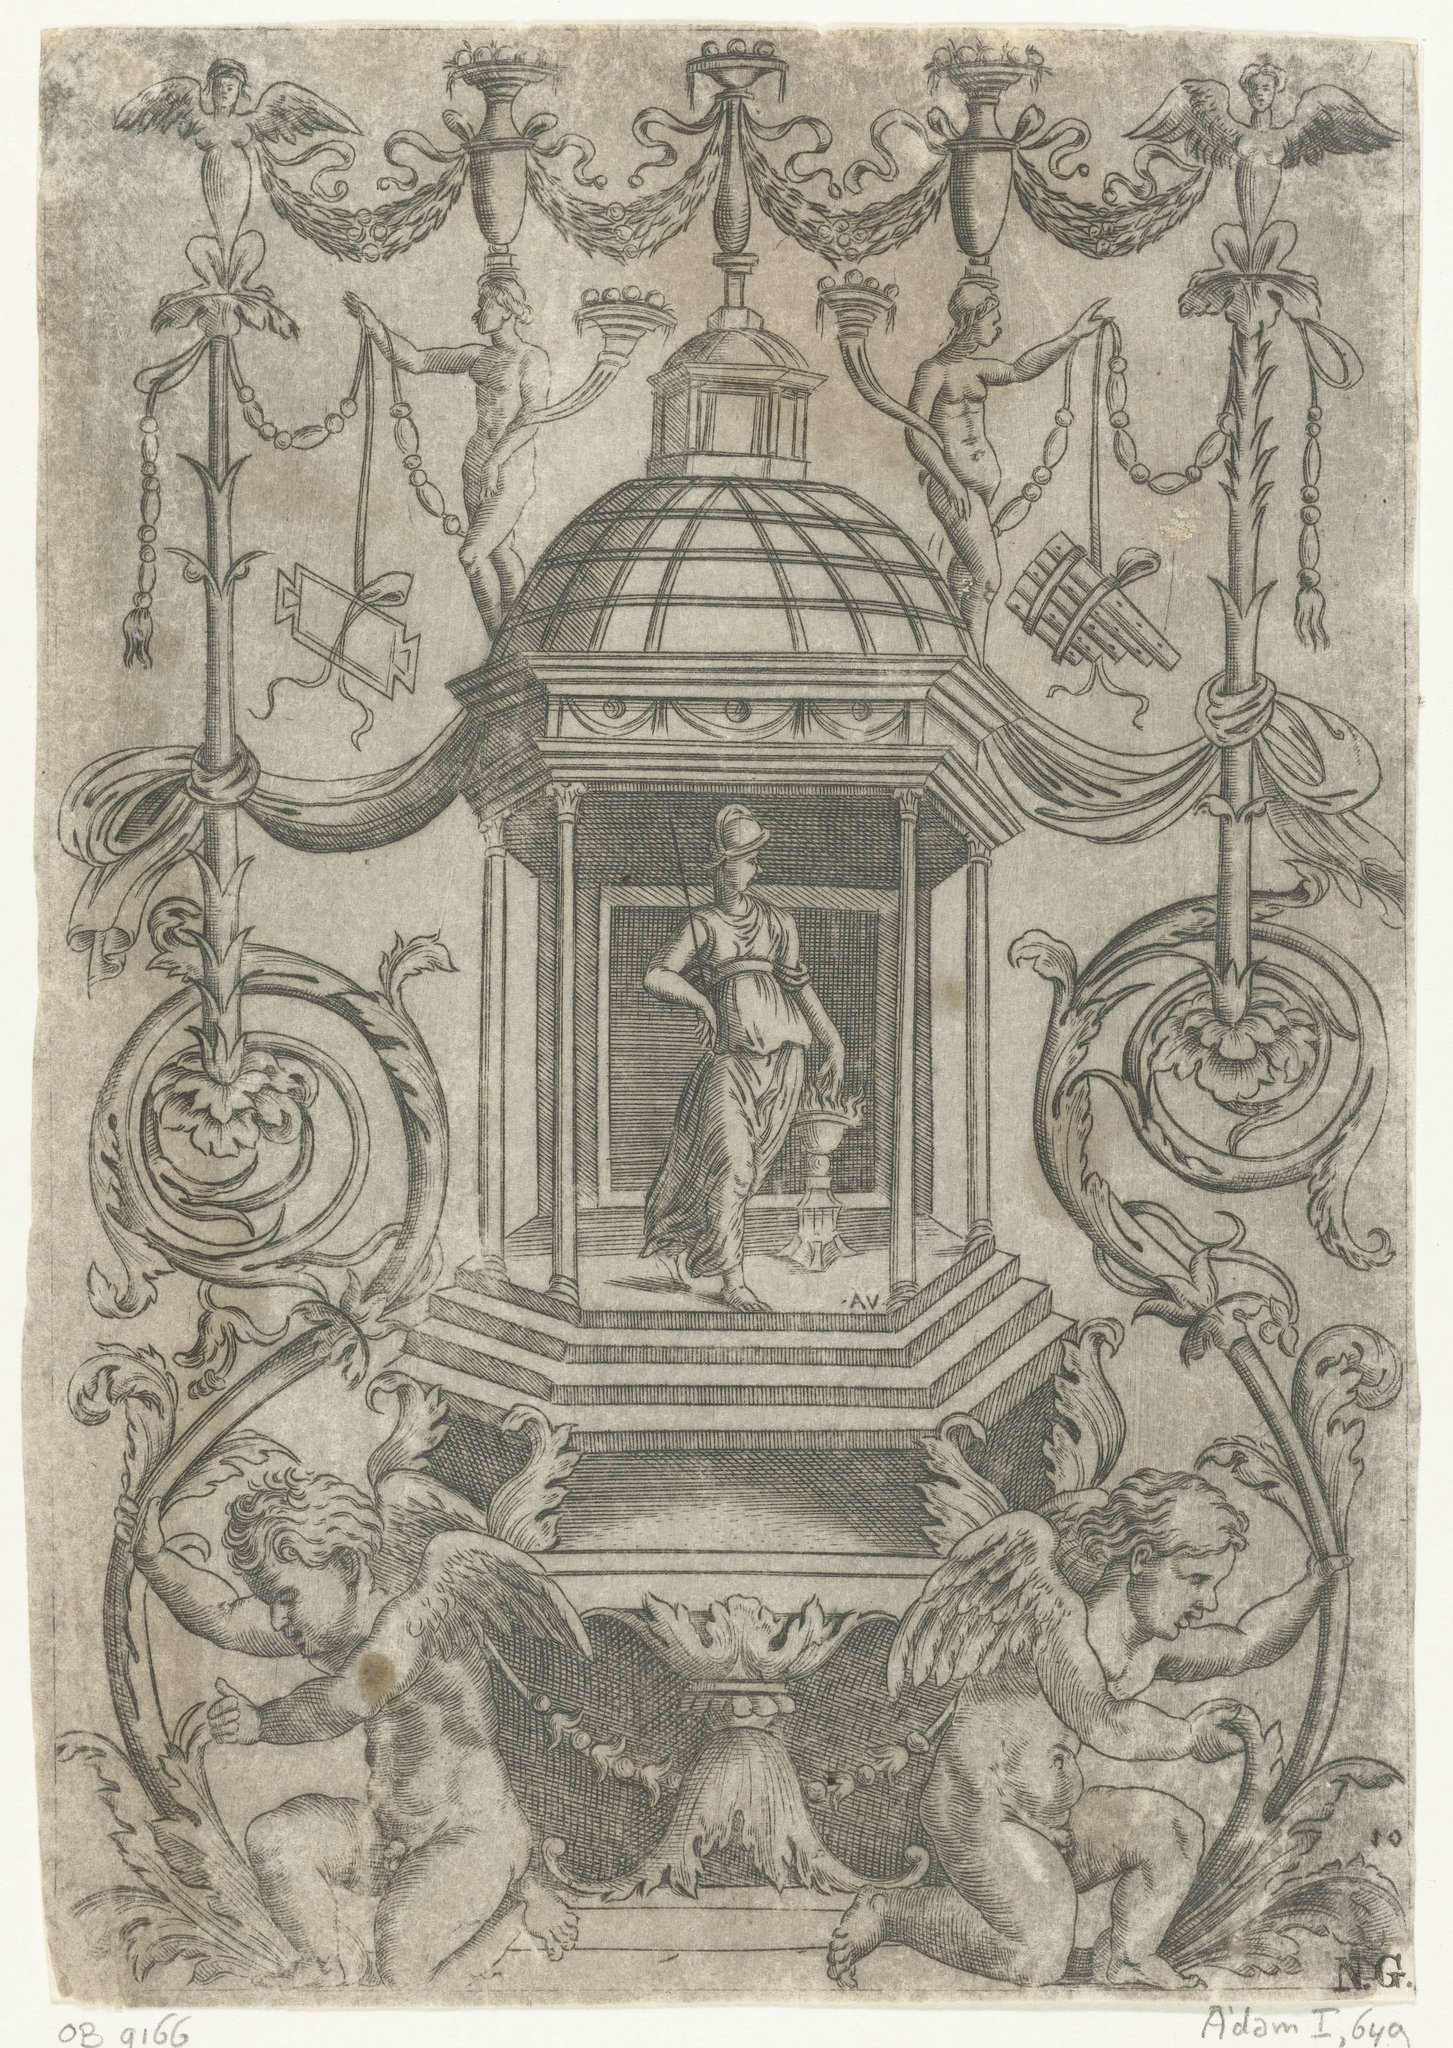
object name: ornament print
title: Vrouw in tempeltje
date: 1500-1536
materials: paper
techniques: engraving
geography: italy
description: Het tempeltje staat op een sokkel, geflankeerd door twee putti die elk een bladrank vasthouden.